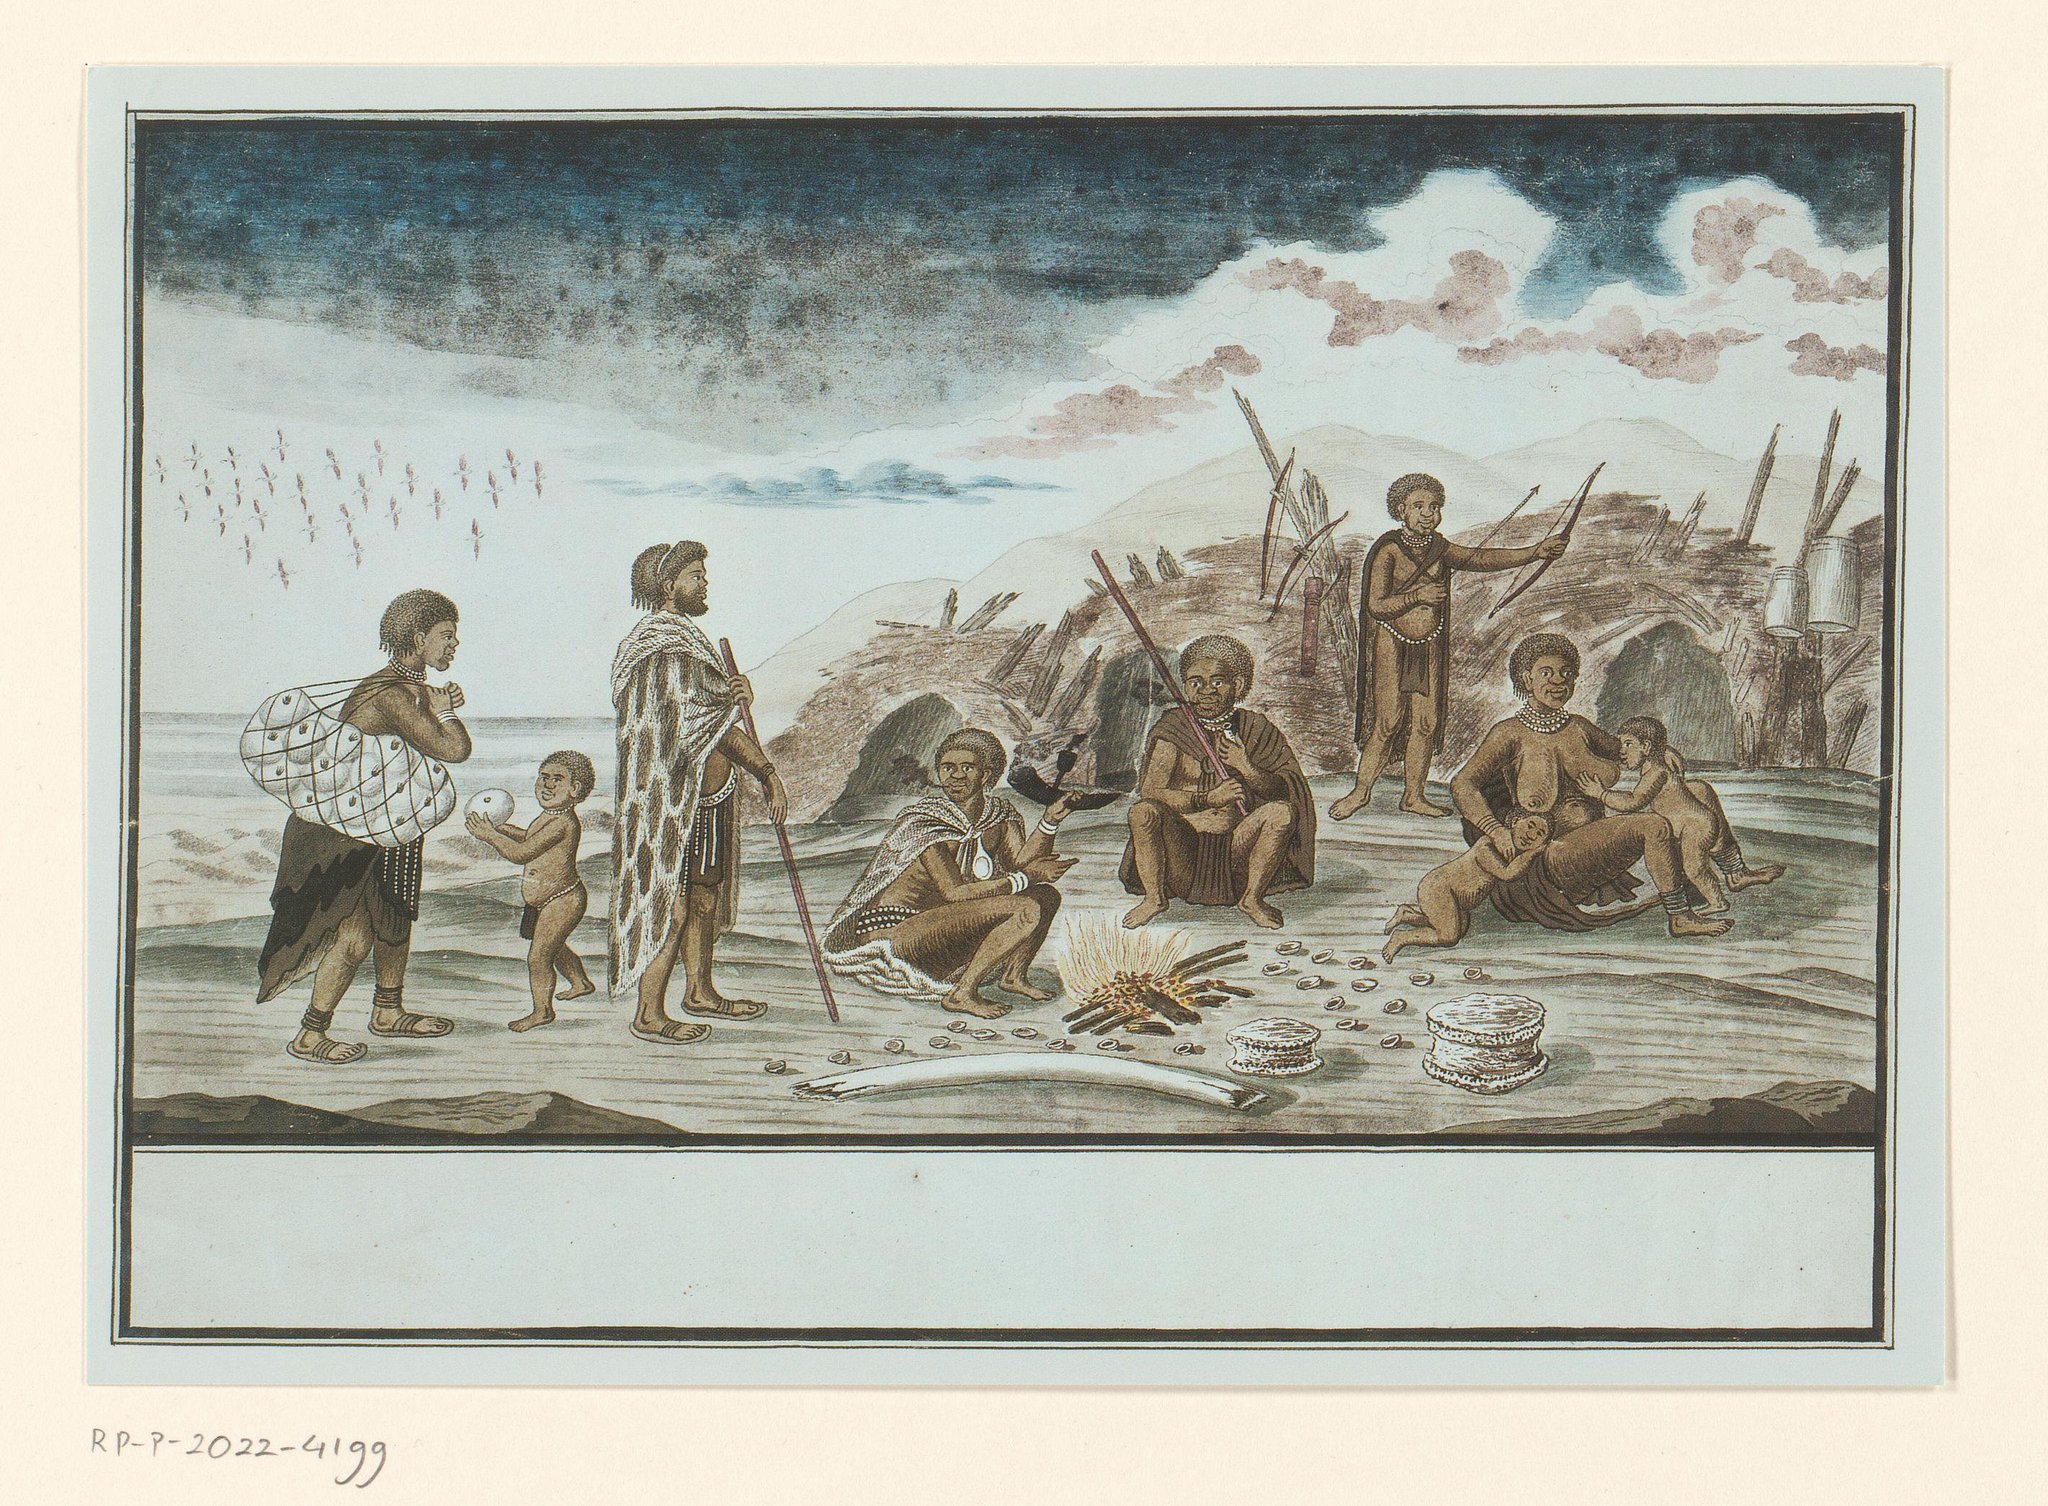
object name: fotomechanisch procedé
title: Uitnodiging van het Rijksmuseum Amsterdam voor de opening van de tentoonstelling: Zuid-Afrika op de kaart. De Atlas Gorden, april 2002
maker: robert jacob gordon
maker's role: draughtsman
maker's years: 1743-1795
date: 2002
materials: paper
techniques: offset printed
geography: amsterdam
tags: african peoples (khoisan)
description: Uitnodiging van het Rijksmuseum Amsterdam voor de opening van de tentoonstelling: Zuid-Afrika op de kaart. De Atlas Gorden, op 13 april 2002. Strandlopers door Robert J. Gordon.